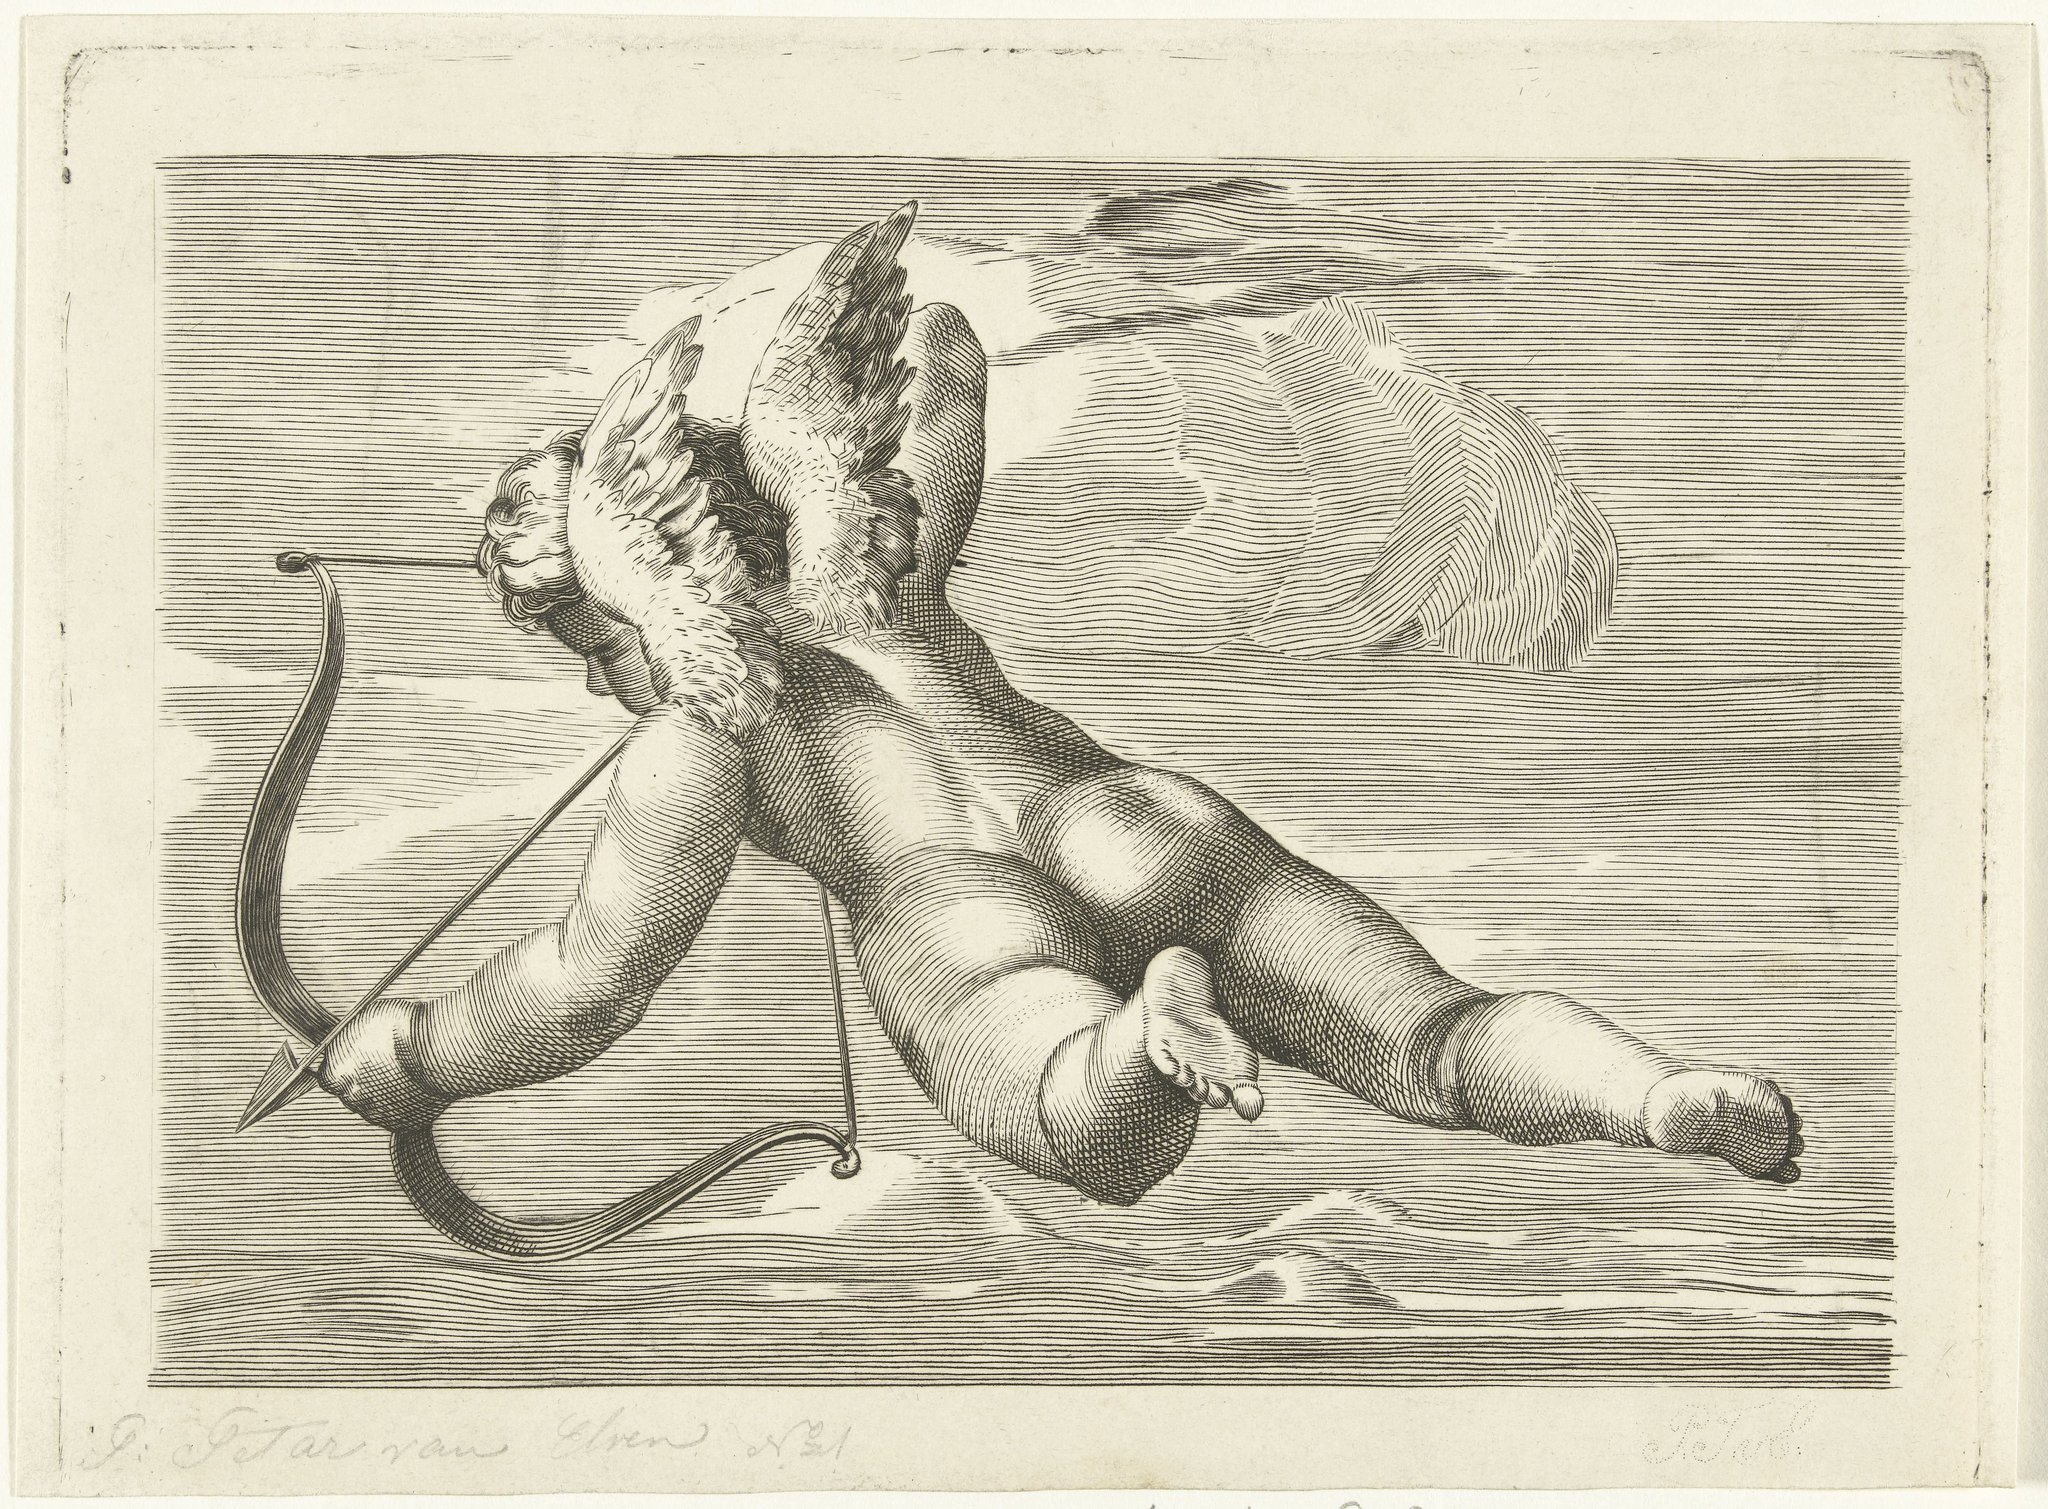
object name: print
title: Cupido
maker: paul tetar van elven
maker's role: print maker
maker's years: 1823-1896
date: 1815-1889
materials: paper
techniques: engraving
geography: haarlem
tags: cupid shooting a dart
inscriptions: collector's mark: Lugt 2228